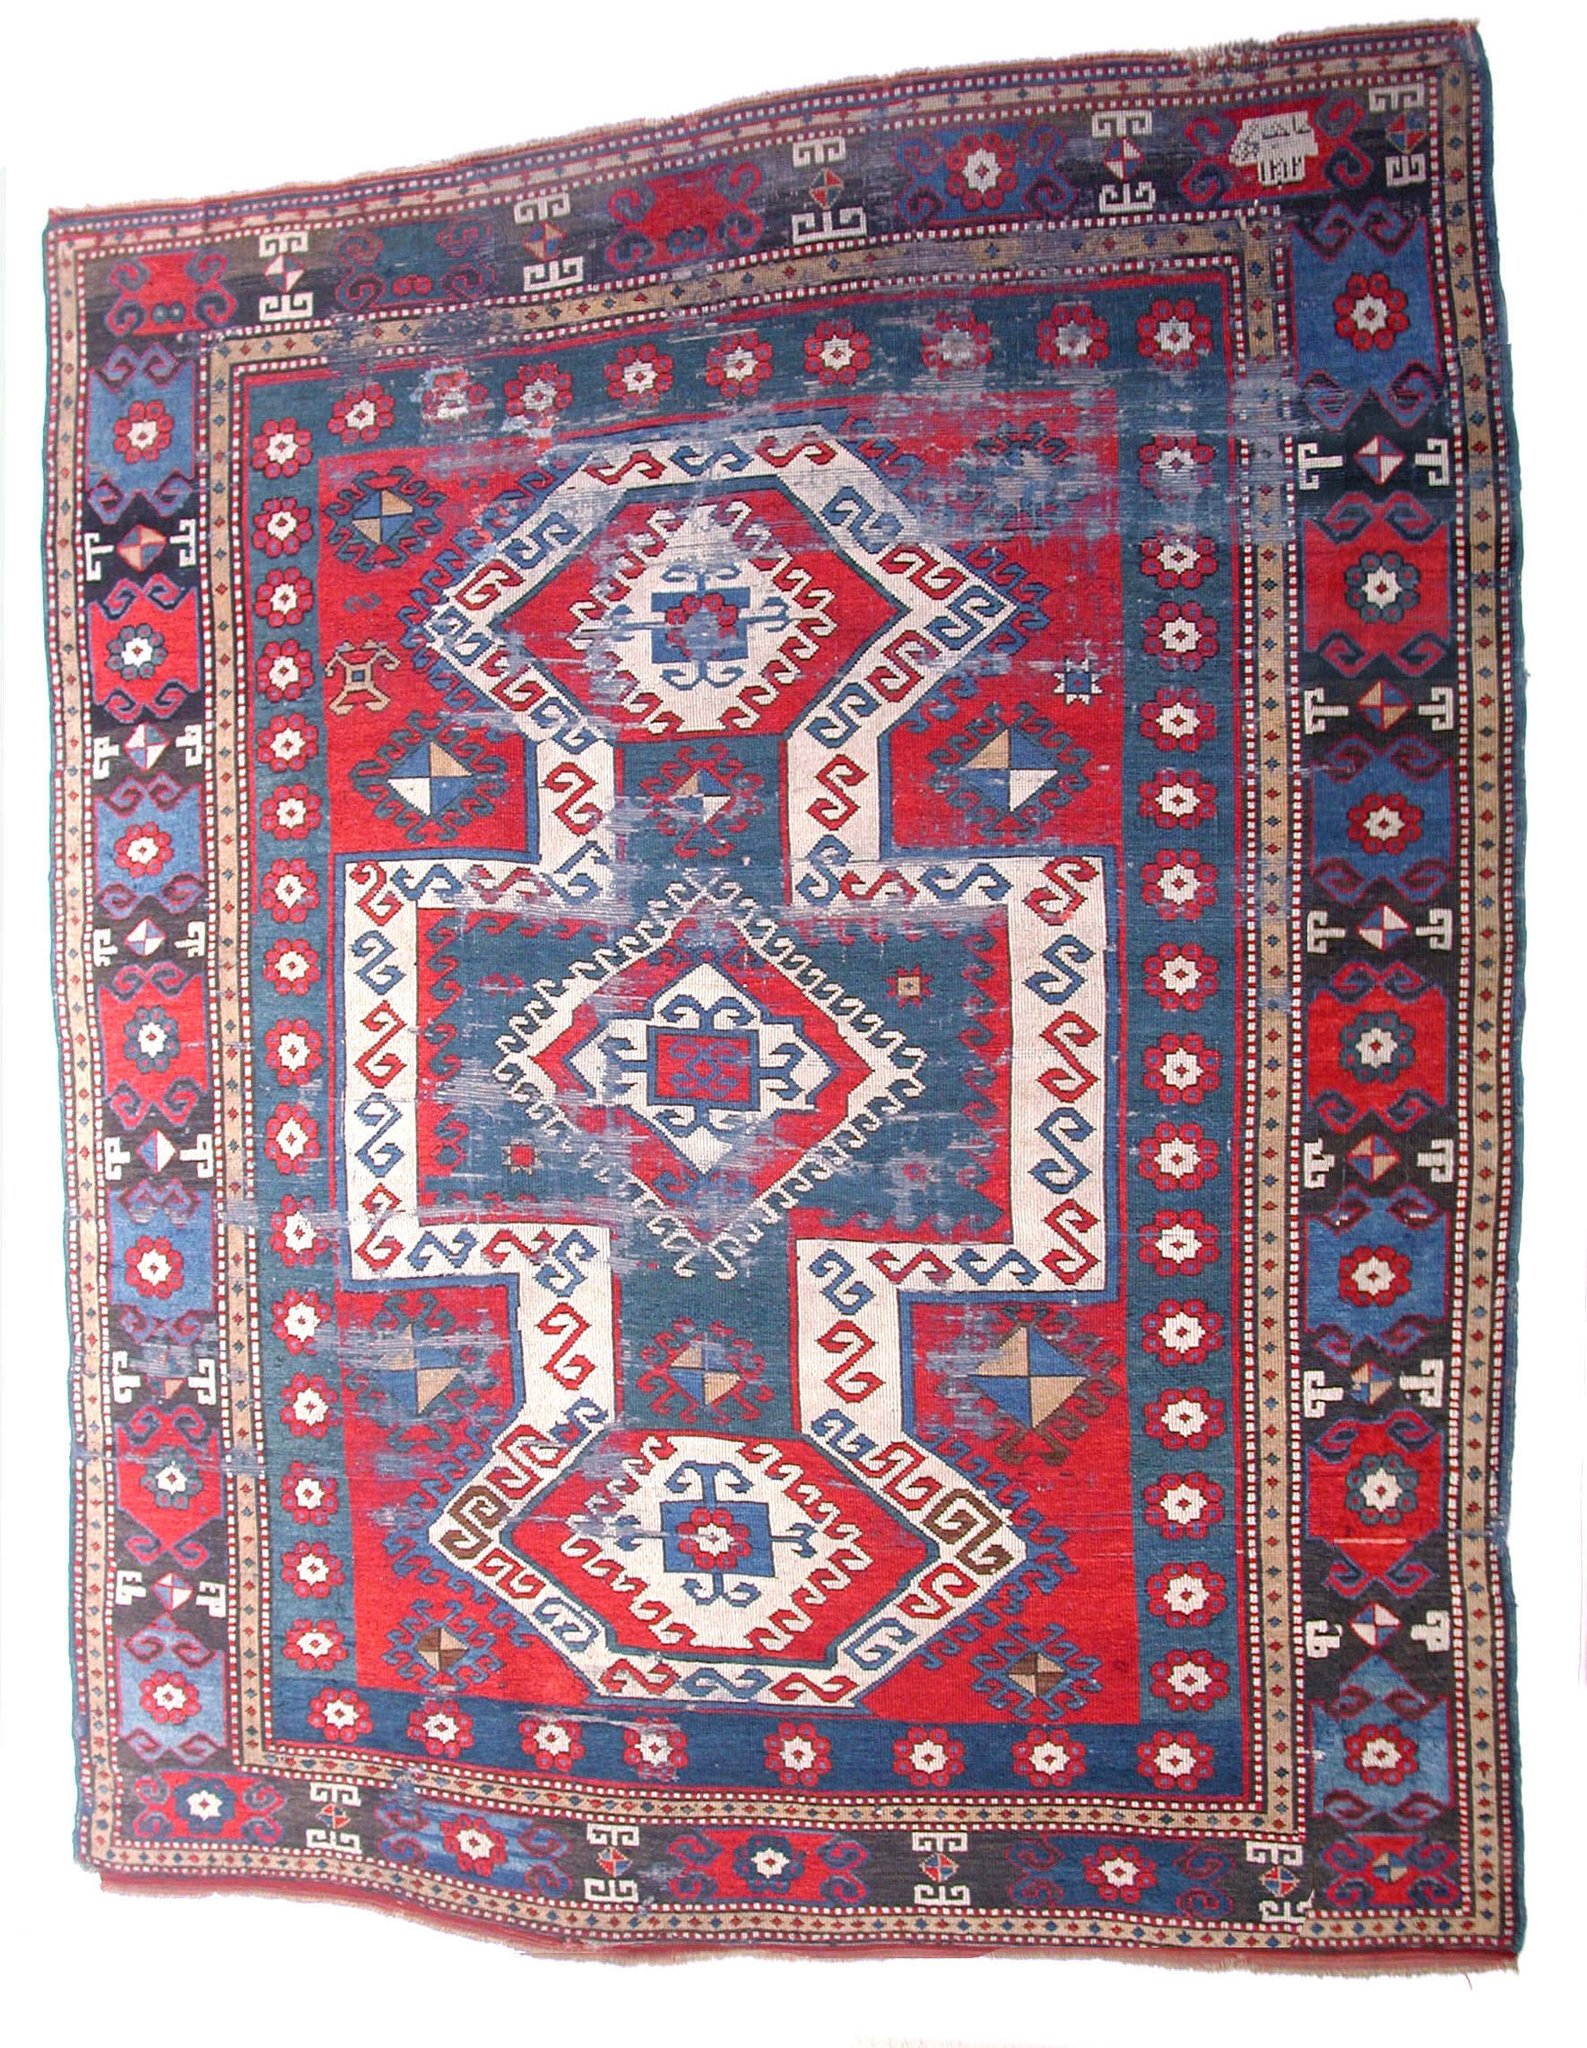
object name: carpet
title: Double-Ended Bellini-Design Kazak Carpet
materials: wool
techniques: weave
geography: caucasus